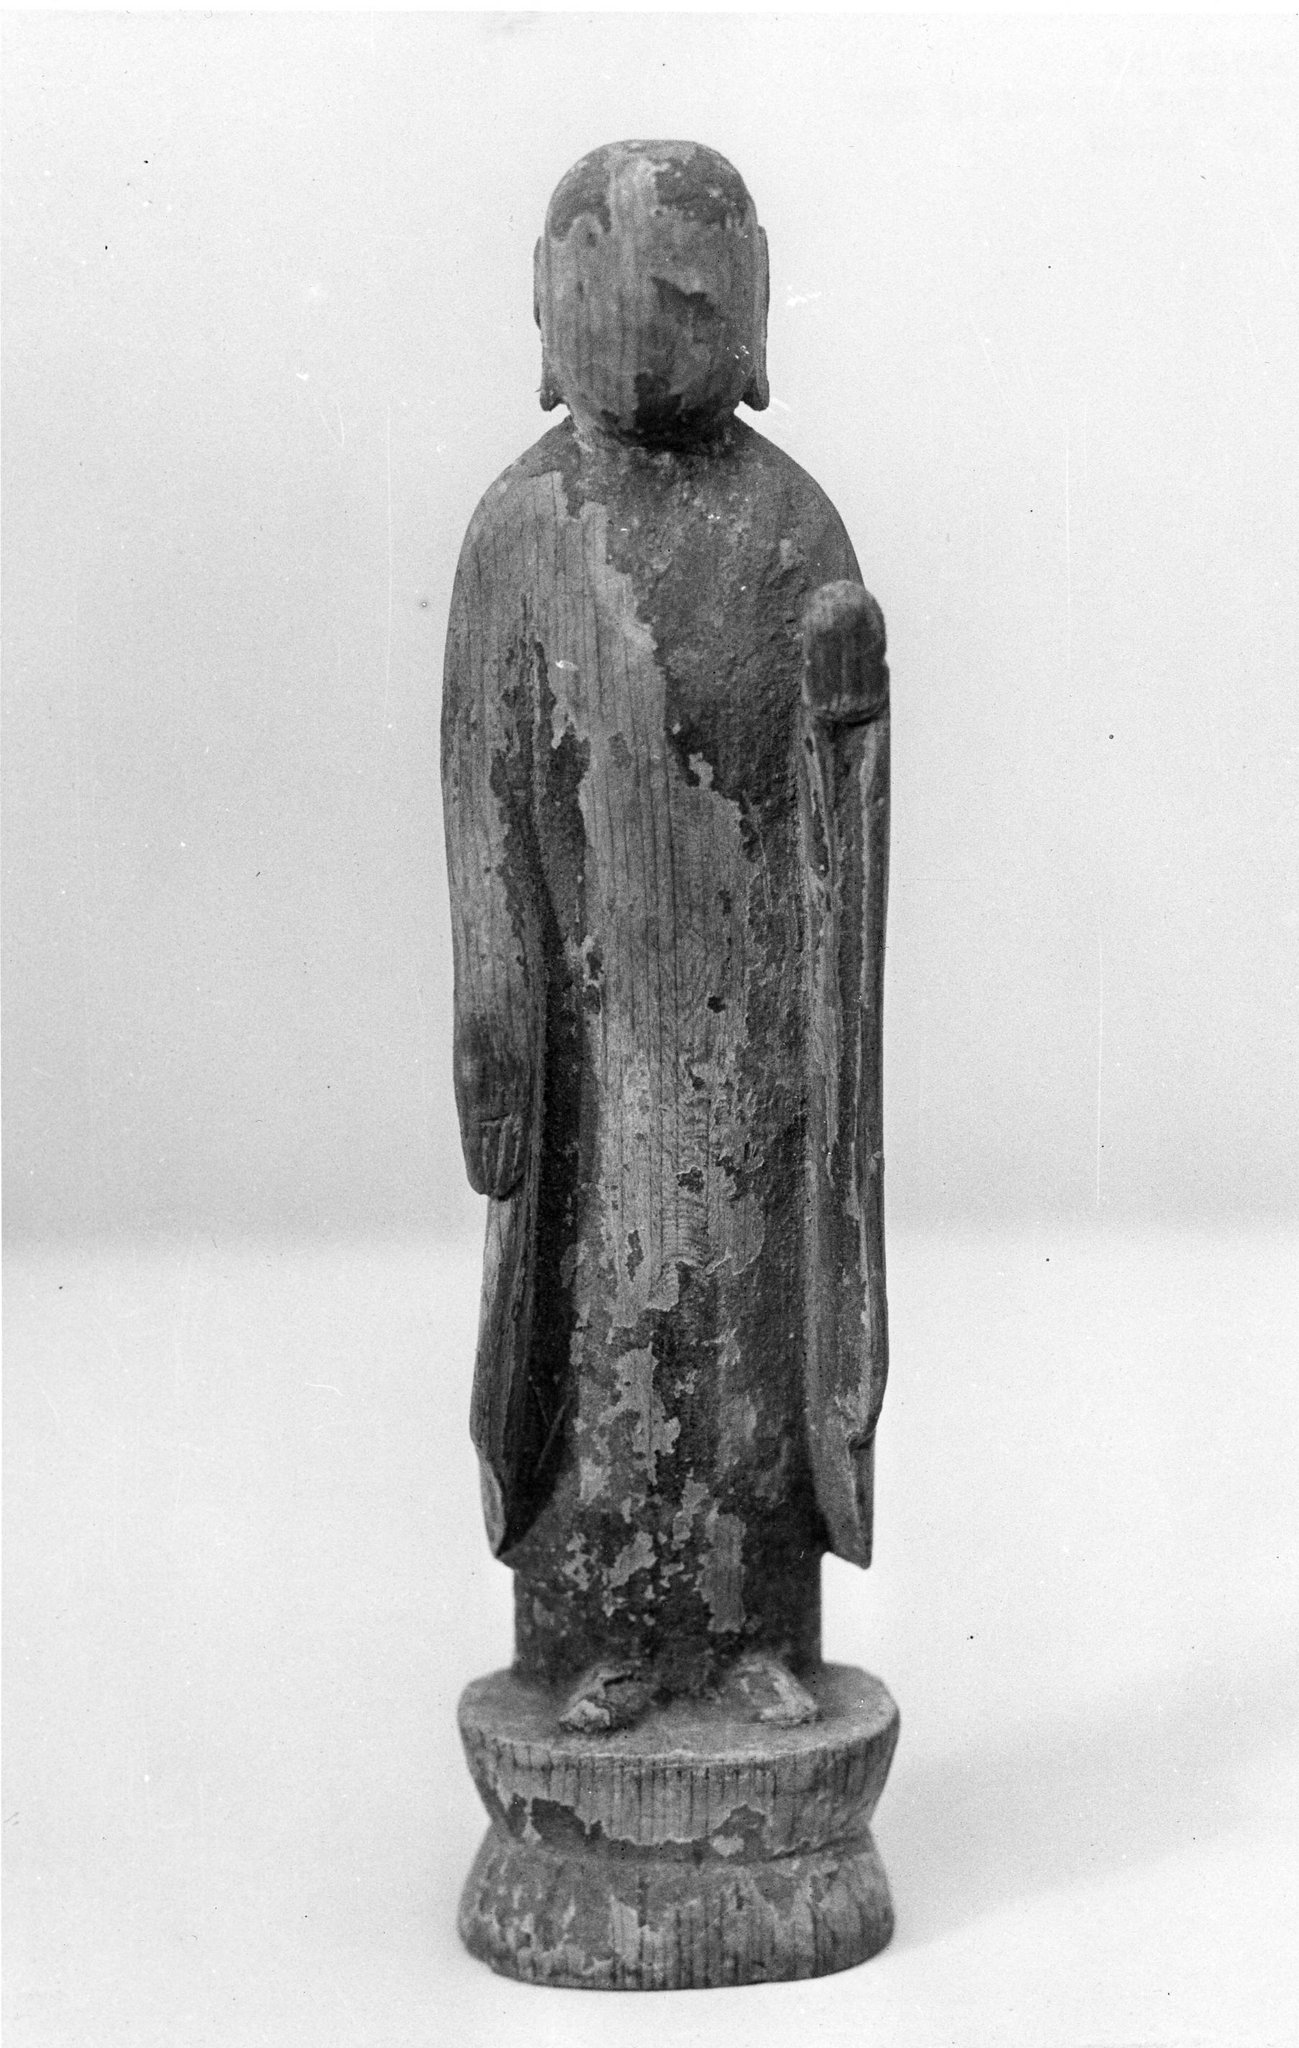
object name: statuette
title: Jizō Bosatsu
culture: japanese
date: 1201-1300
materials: wood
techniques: painting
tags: buddhism,bodhisattvas